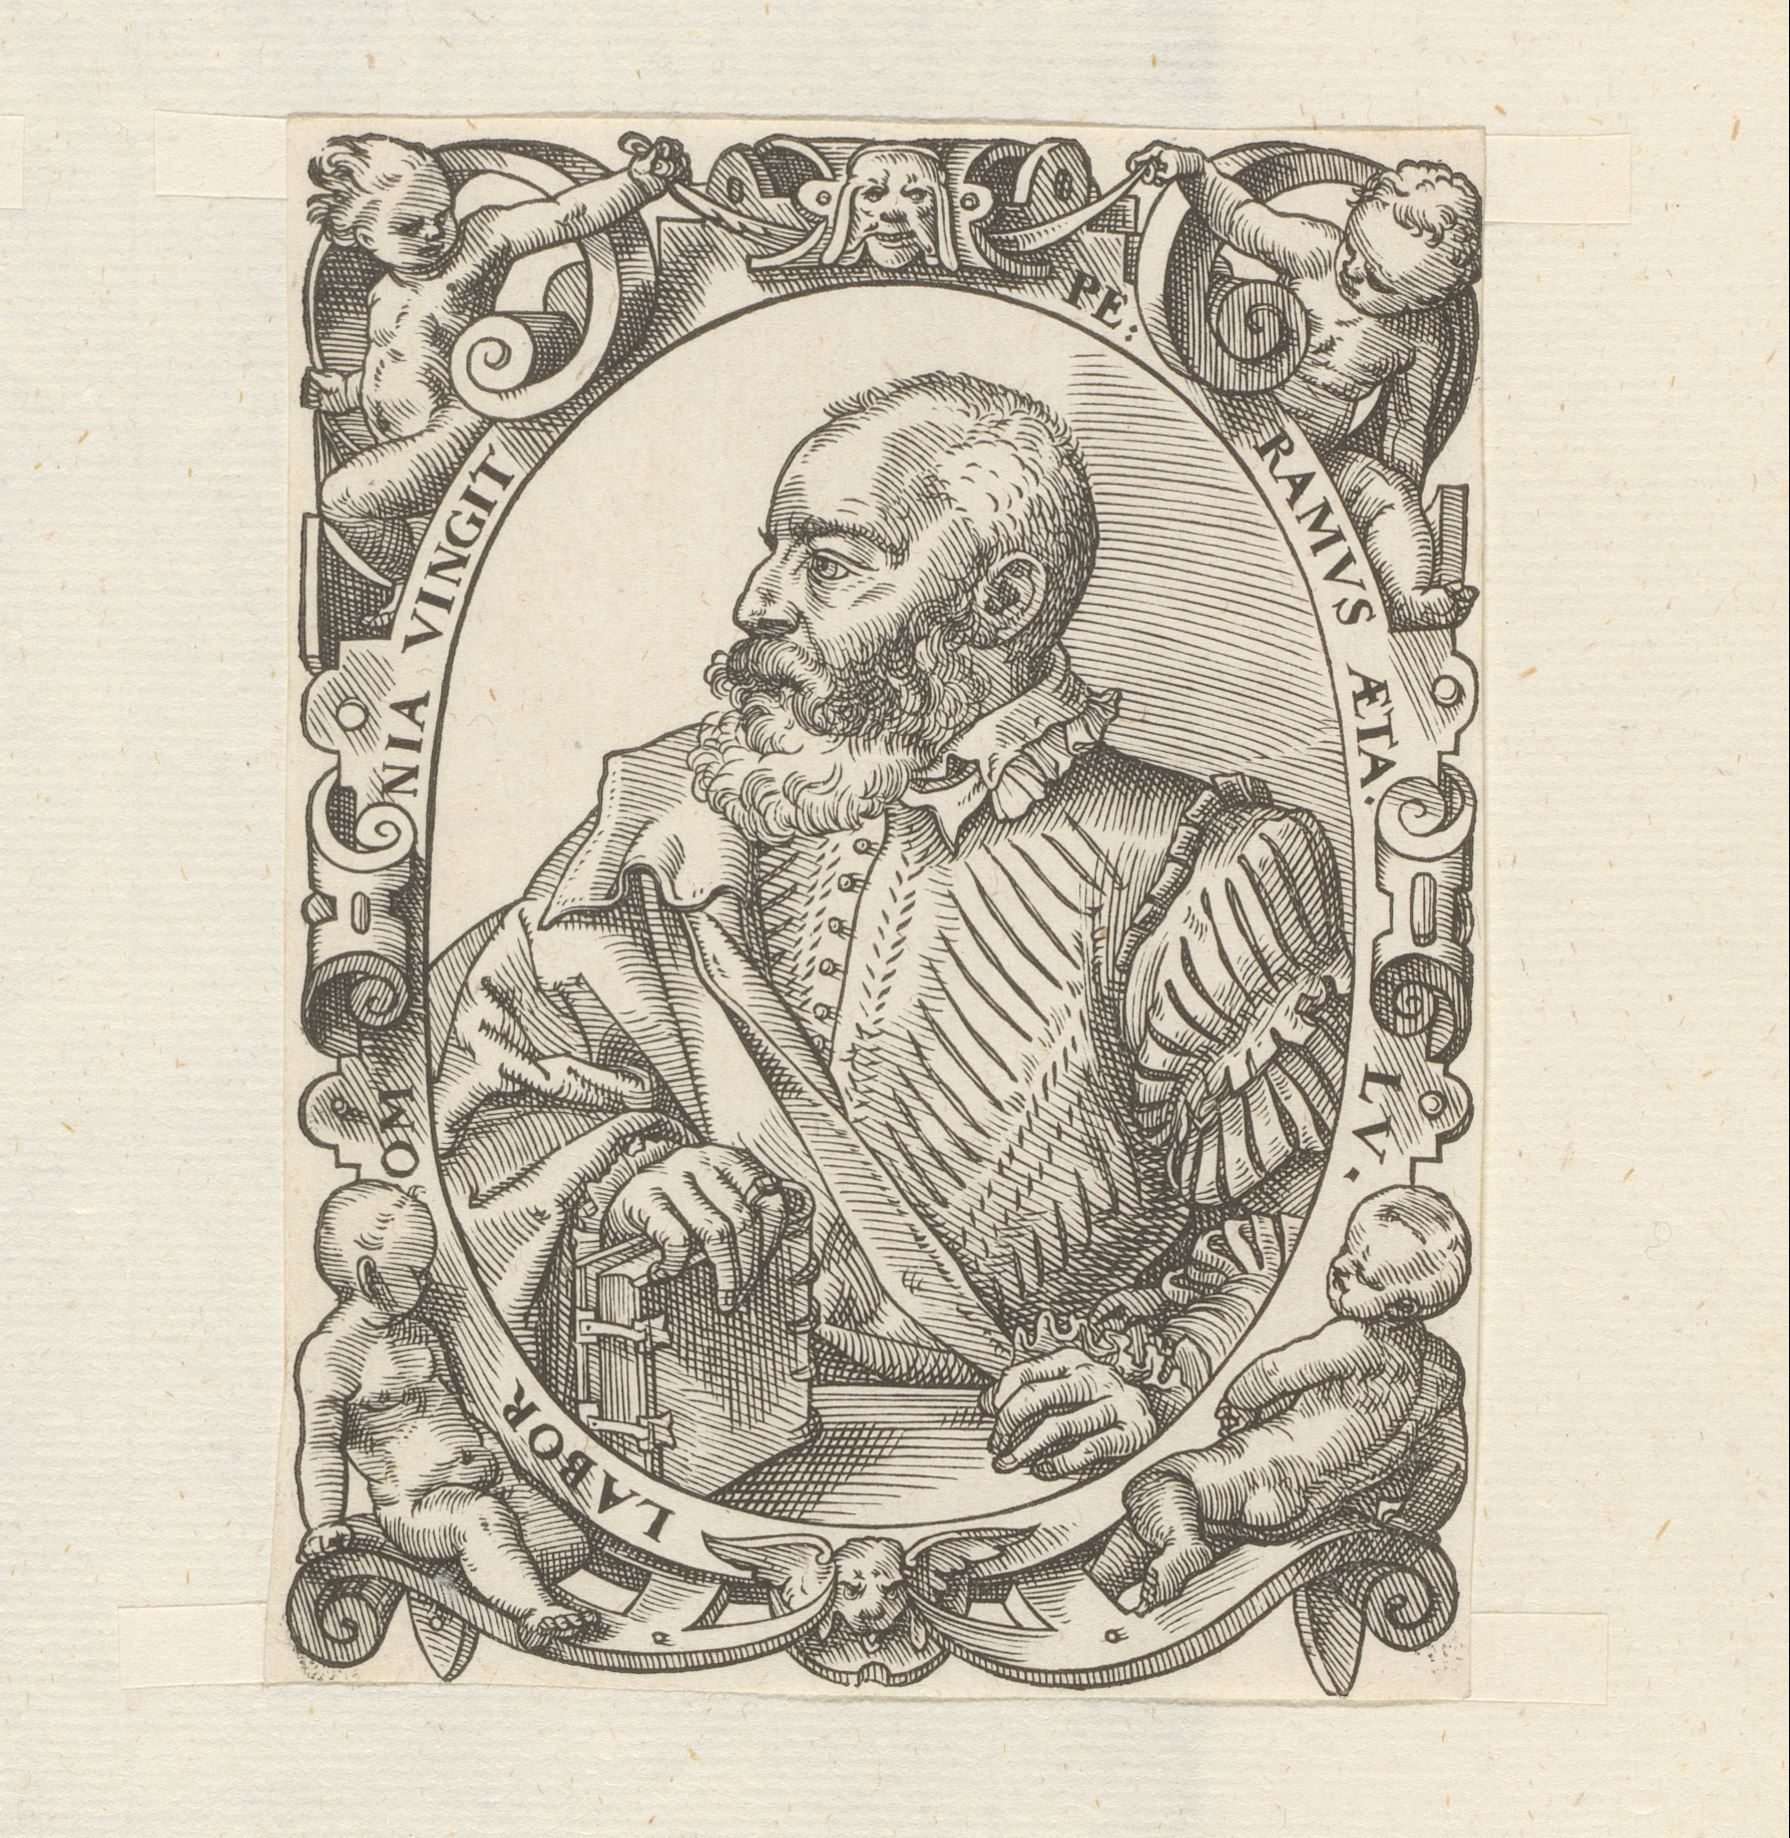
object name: book illustration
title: Portret van Petrus Ramus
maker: Anonymous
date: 1549-1584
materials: paper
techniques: woodcut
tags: paris, historical persons, scholar, philosopher (+ portrait of scholar, scientist)